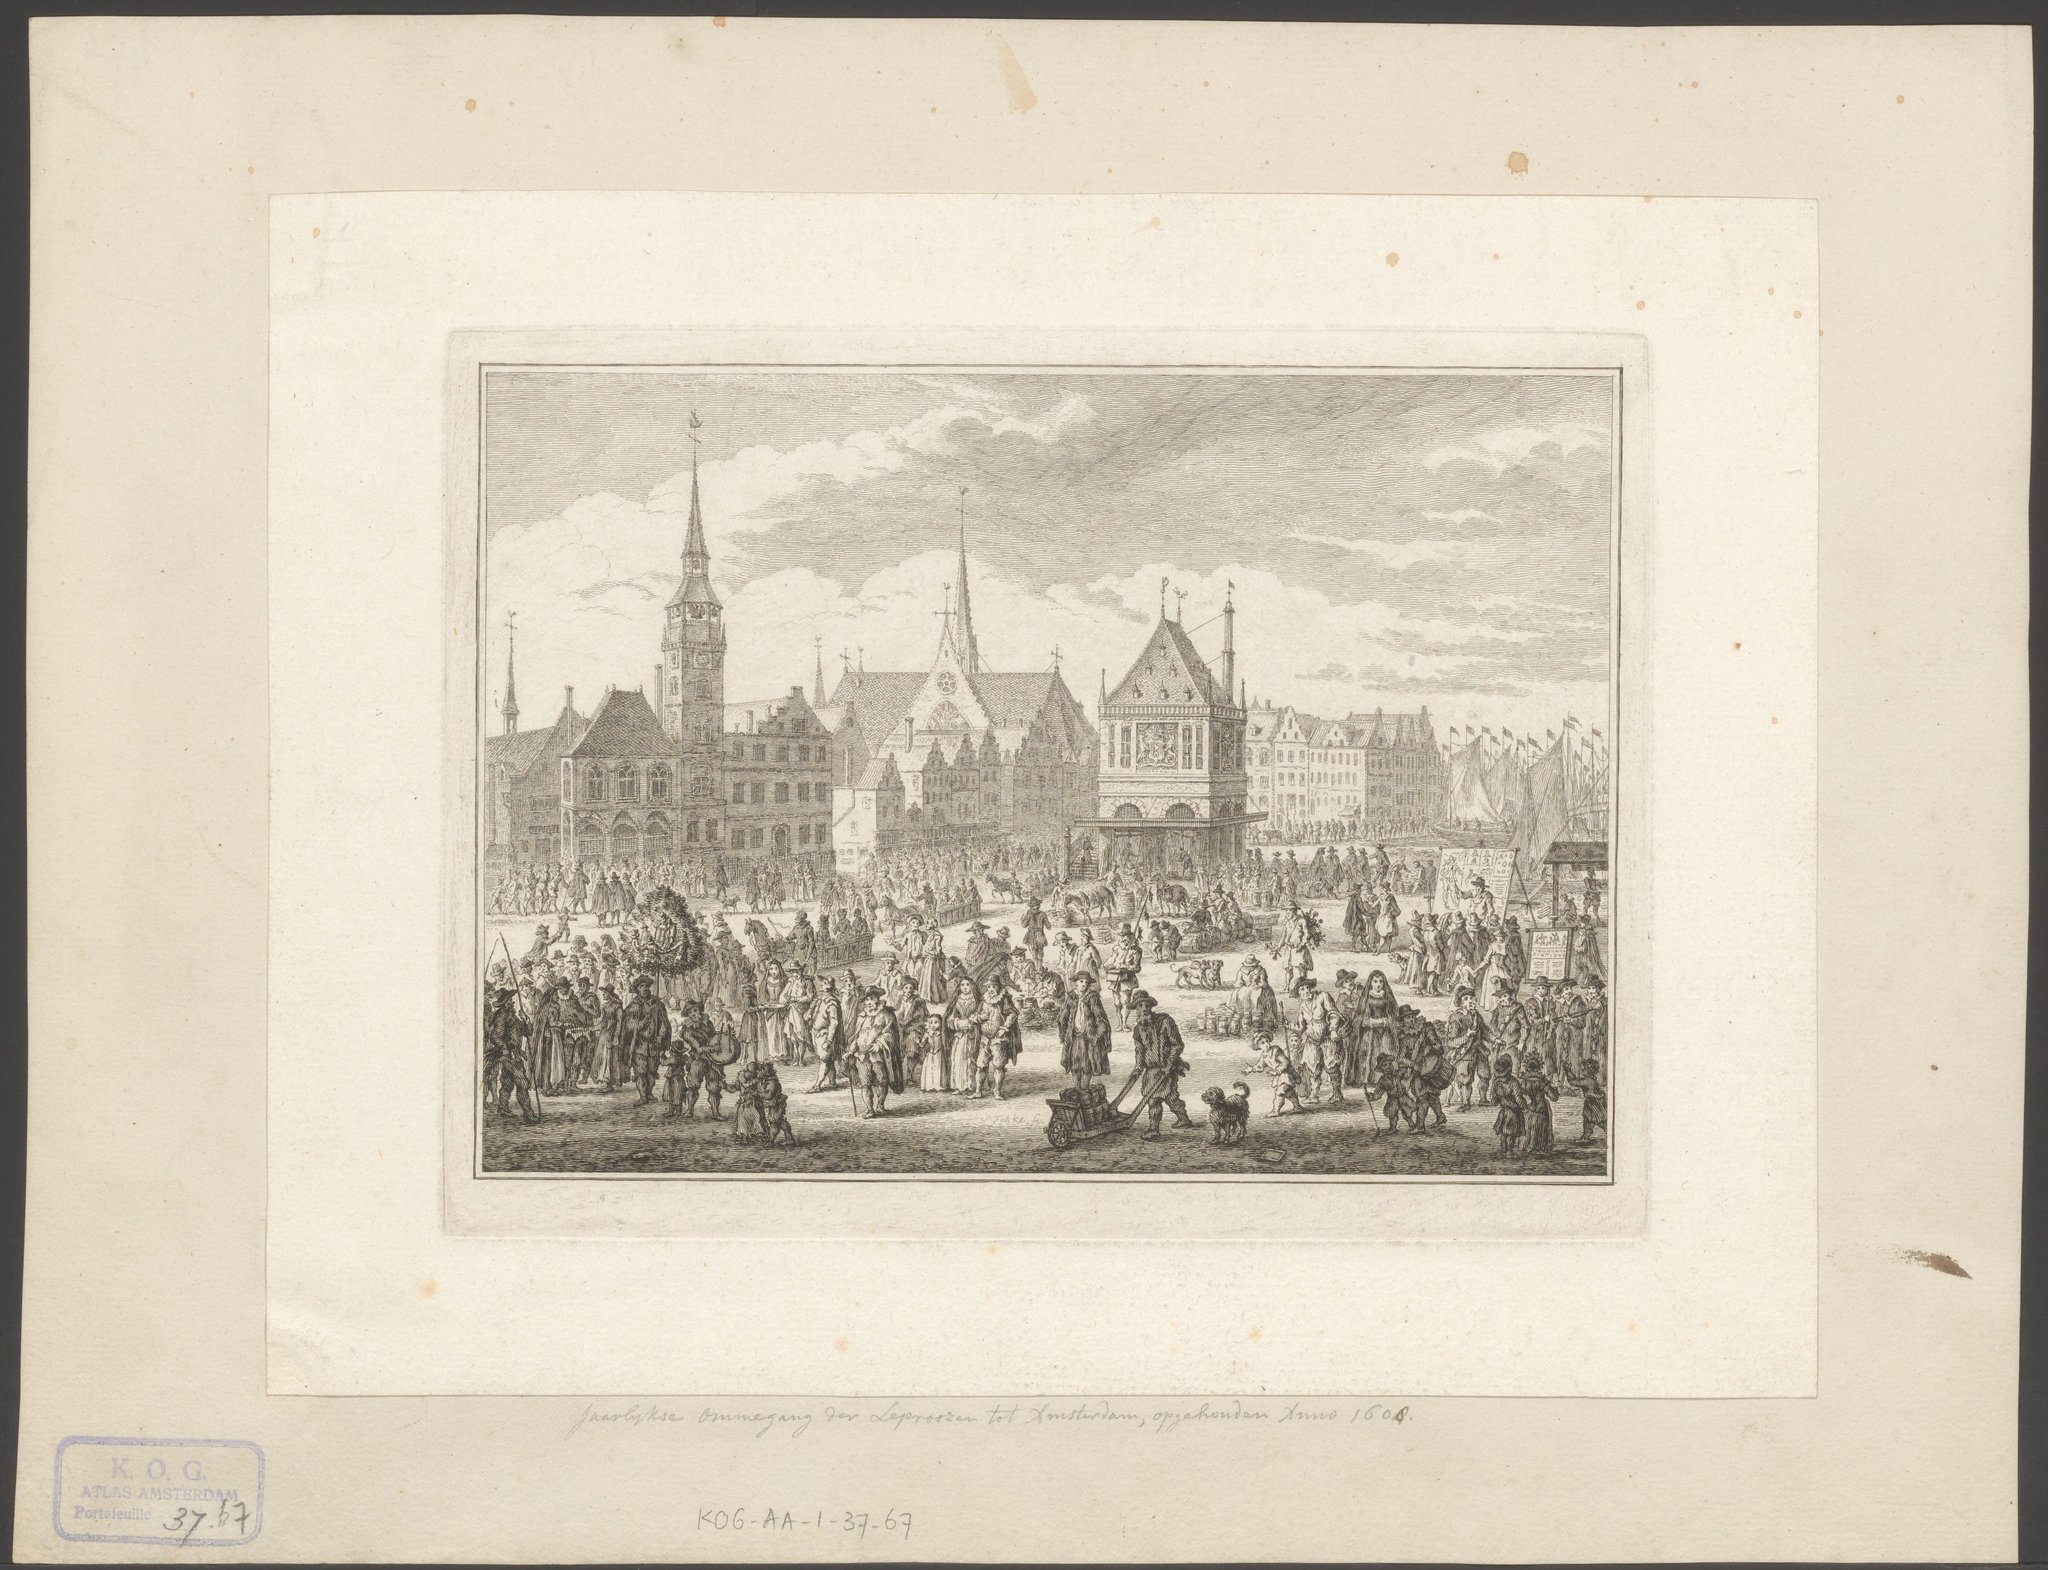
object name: print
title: Koppermaandag met leprozenoptocht te Amsterdam, 1604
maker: simon fokke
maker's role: draughtsman, print maker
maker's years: 1712-1784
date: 1769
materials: paper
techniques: etching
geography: northern netherlands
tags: 'blue monday', leper's procession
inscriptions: collector's mark: Lugt 1641b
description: Latere staat van deze prent (met tekst) ook gebruikt in: Atlas van de stad Amsterdam (...) / Atlas de la ville d'Amsterdam (...). Amsterdam: Reinier (II) Ottens, Pieter Yver, Johannes Smit, Frederik Willem Greebe, Albert van der Kroe en Jan Christiaan Sepp, 1769, dl. 3. En in: Elwe, Jan Barend. Atlas van de wereldberoemde koopstad Amsteldam (...). Amsterdam: Jan Barend Elwe, 1804.